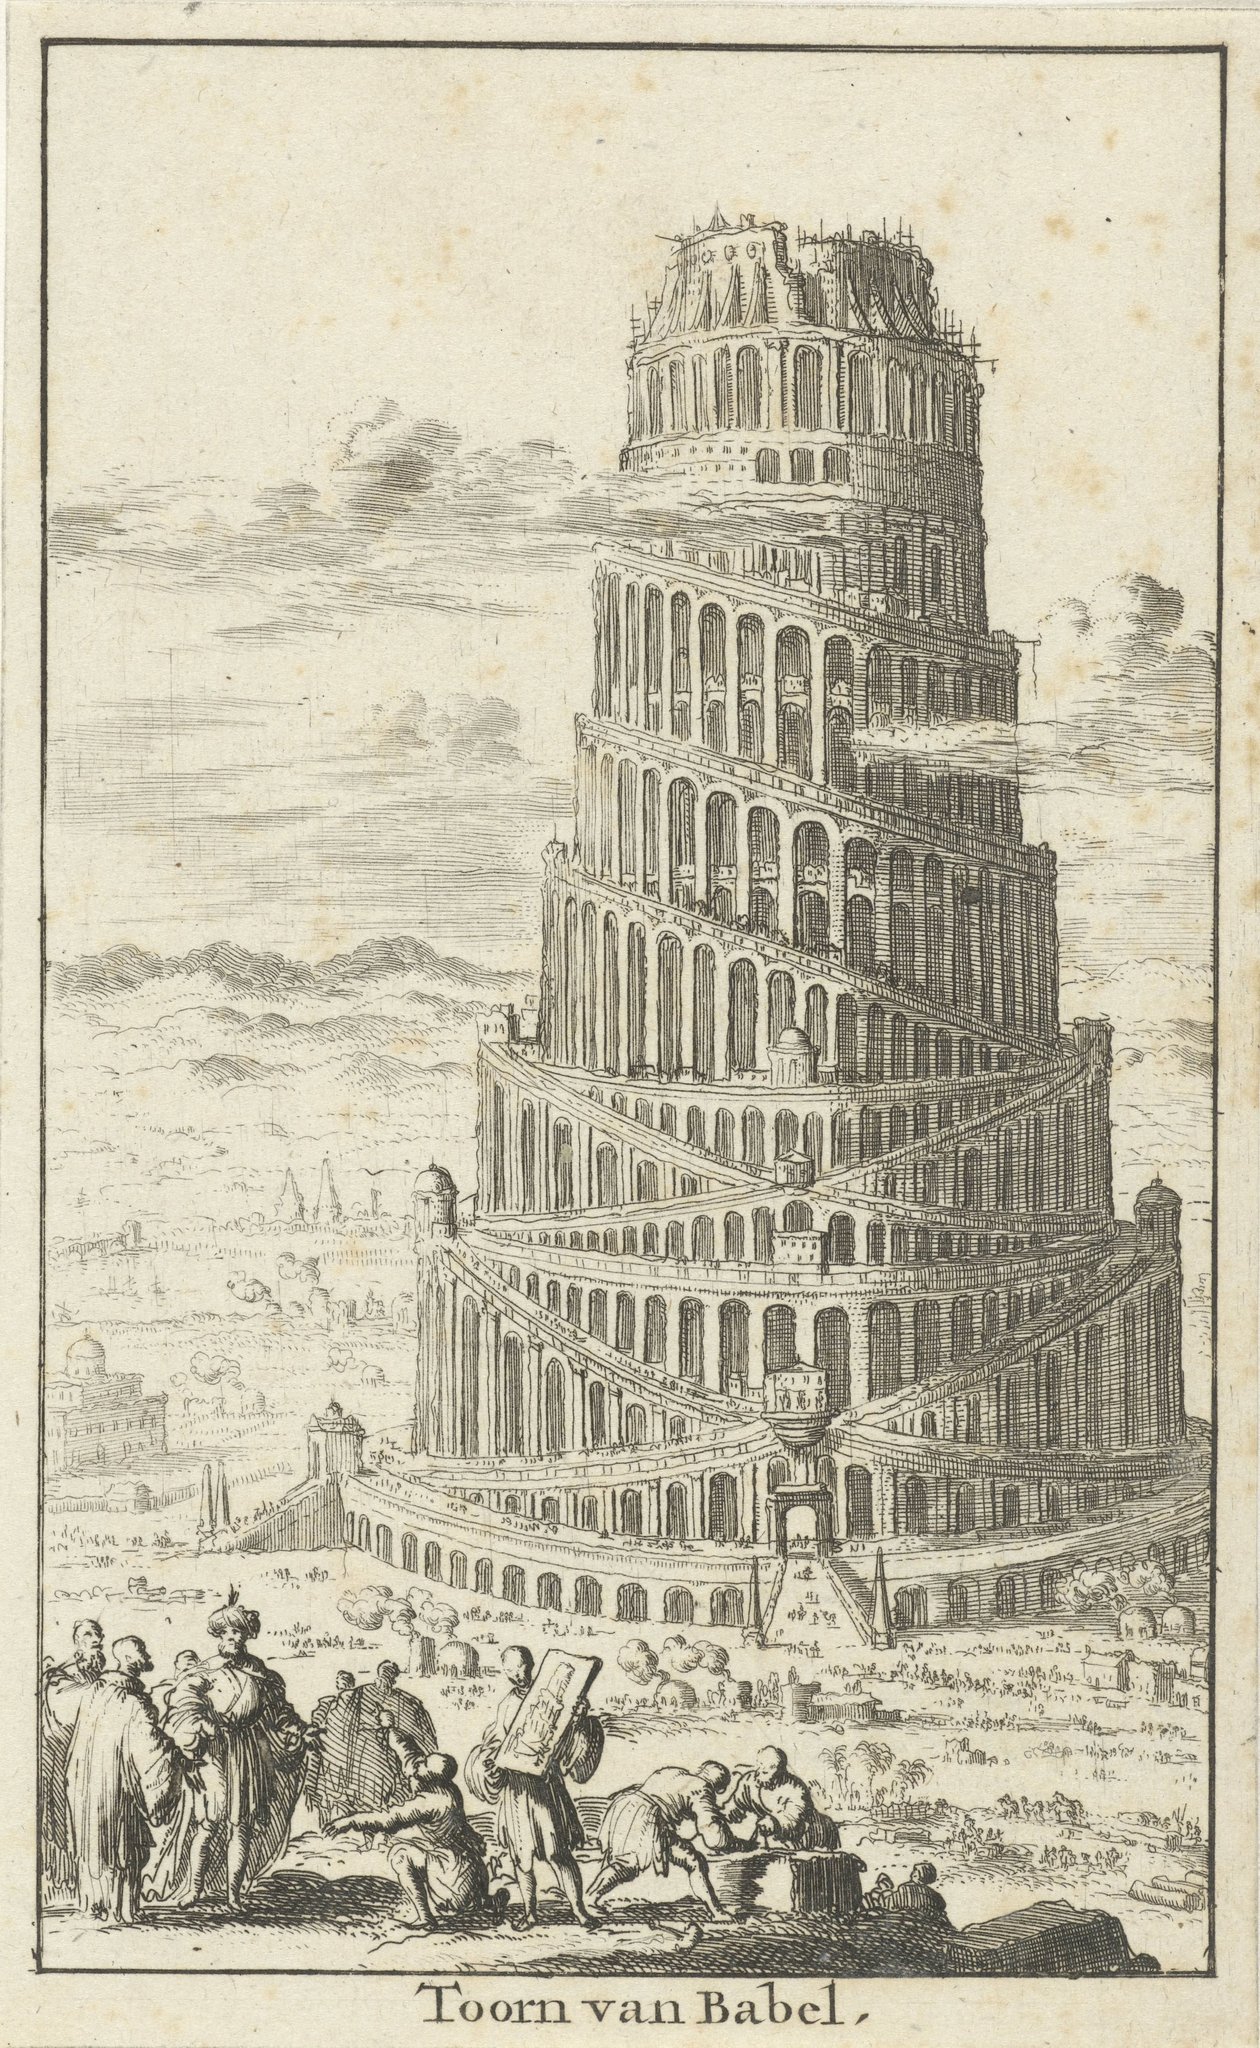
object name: book illustration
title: Toren van Babel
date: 1682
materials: paper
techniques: etching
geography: amsterdam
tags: the building of the tower of babel; nimrod may be present, supervising or assisting the construction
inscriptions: collector's mark: Lugt 2228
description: Illustratie opgenomen in: Cunaeus, Petrus. De republyk der Hebreen, of gemeenebest der joden, 3 delen. Amsterdam: Wilhelmus Goeree, 1682, dl. 1, p. 403.